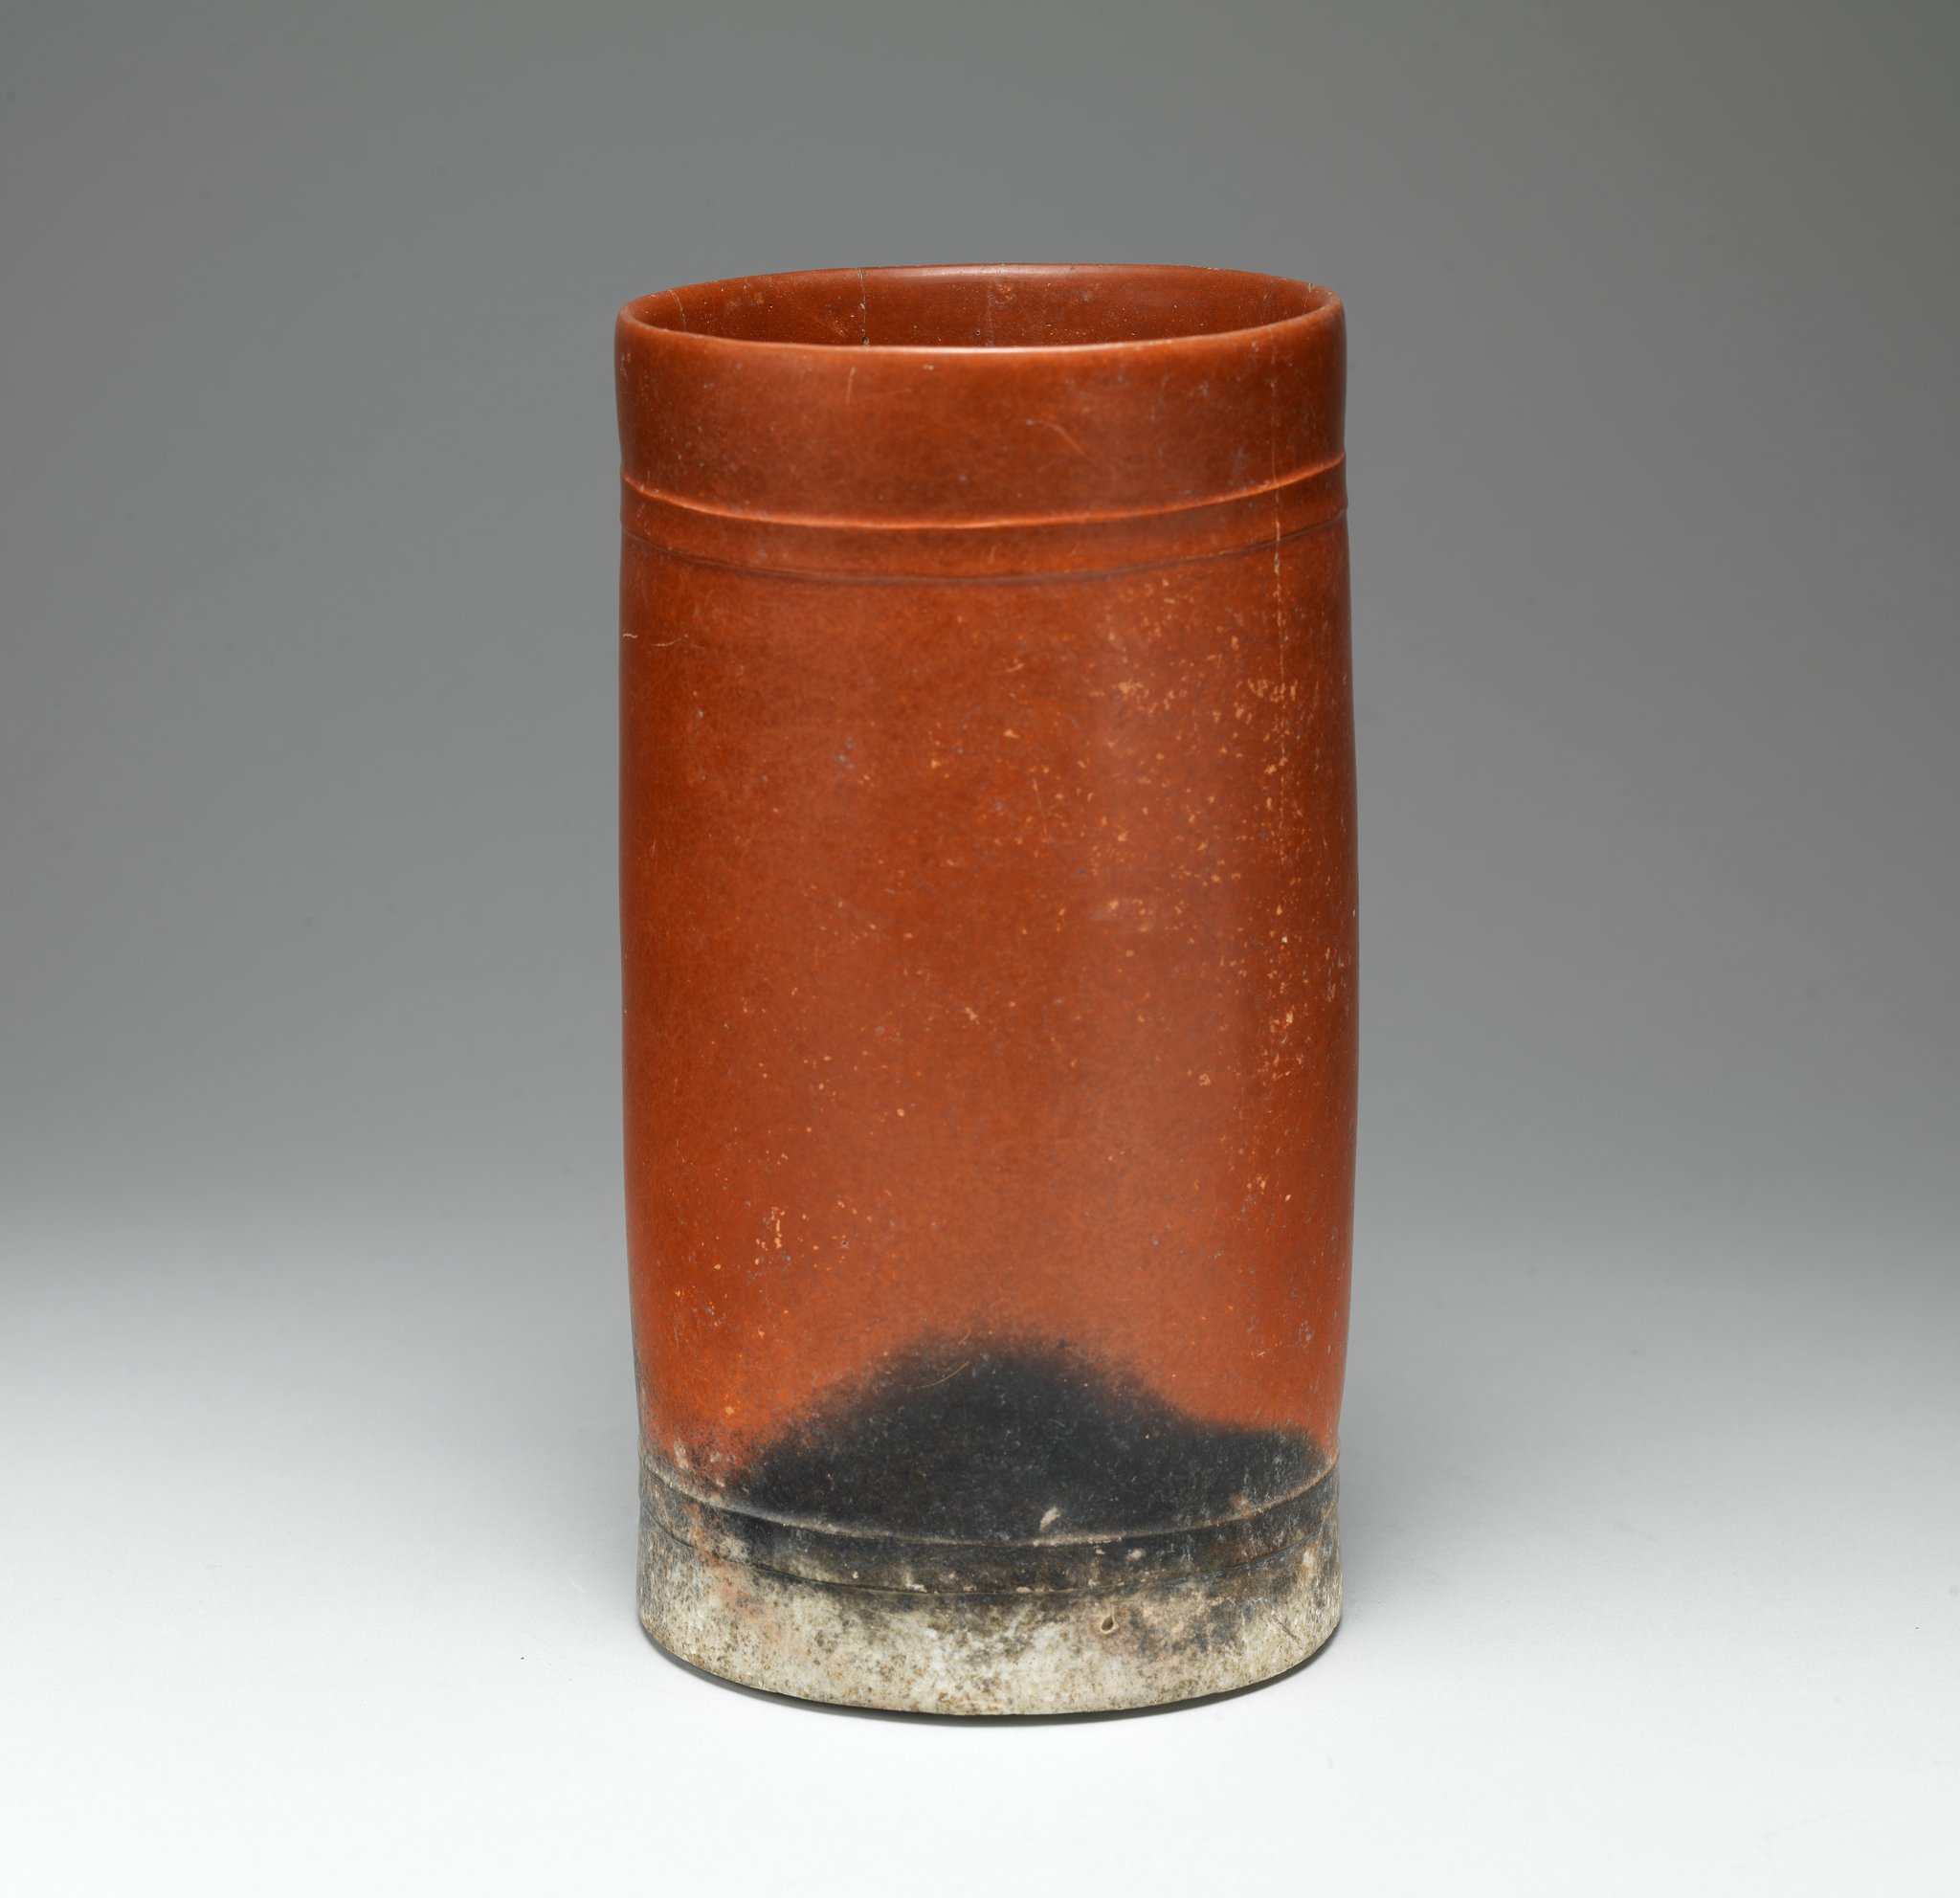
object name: vessel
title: Cylindrical Vessel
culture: maya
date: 1-200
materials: ceramic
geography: guatemala